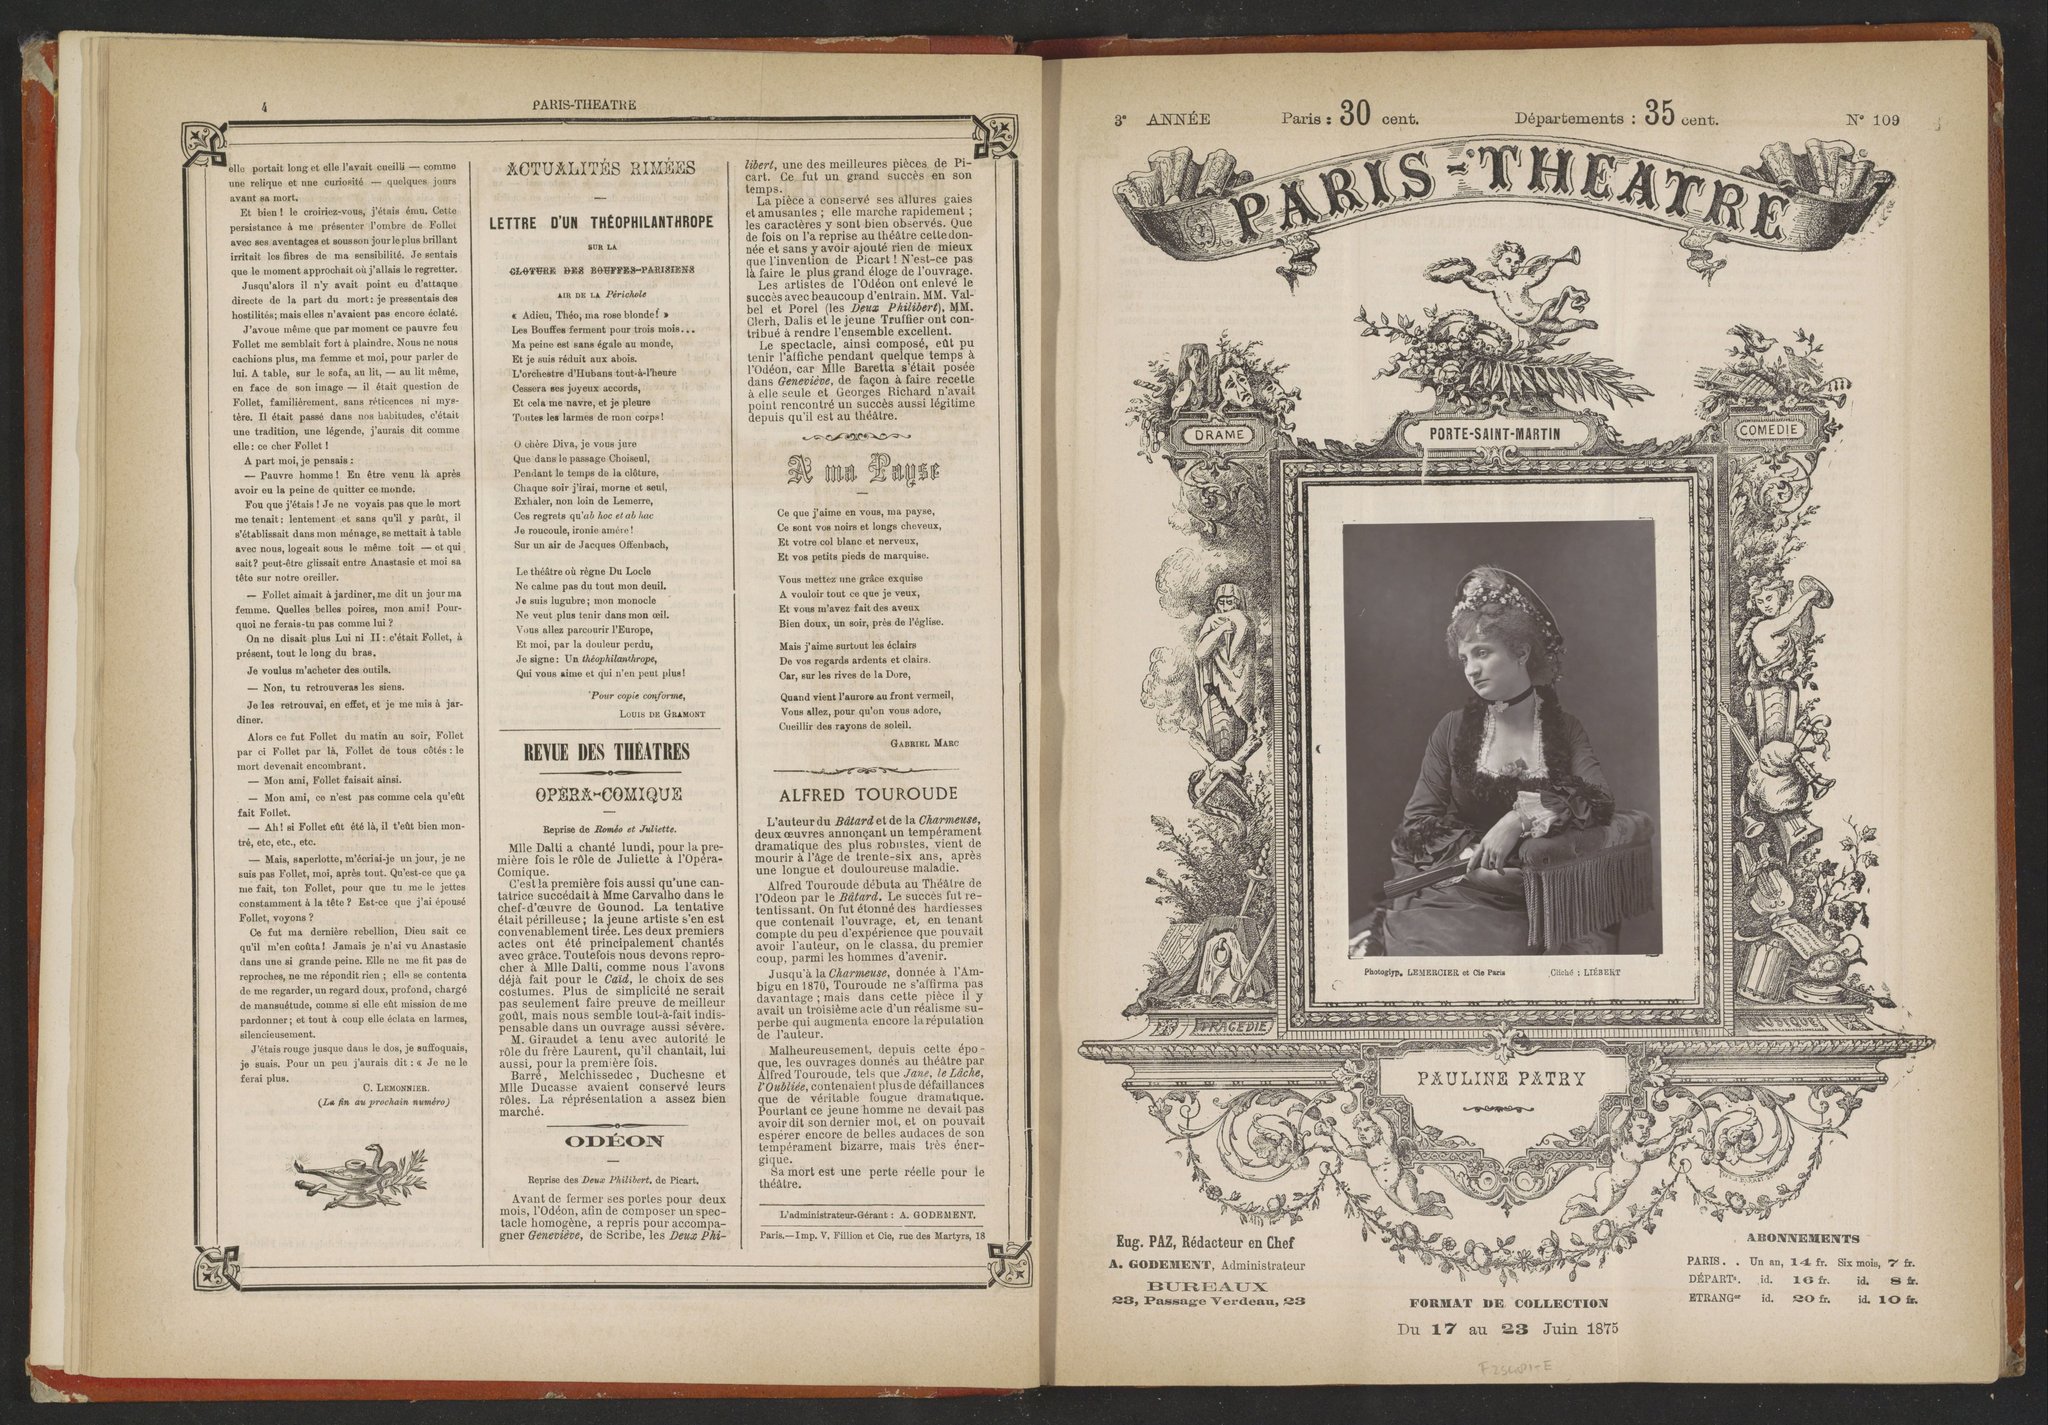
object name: photomechanical print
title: Portret van Pauline Patry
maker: alphonse-justin liébert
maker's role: fotograaf, marinier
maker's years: 1827-1914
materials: paper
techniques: woodburytype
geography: france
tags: actrice, pauline patry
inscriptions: inscription: ‘Du 17 au 23 Juin 1875’, number: ‘No 109’